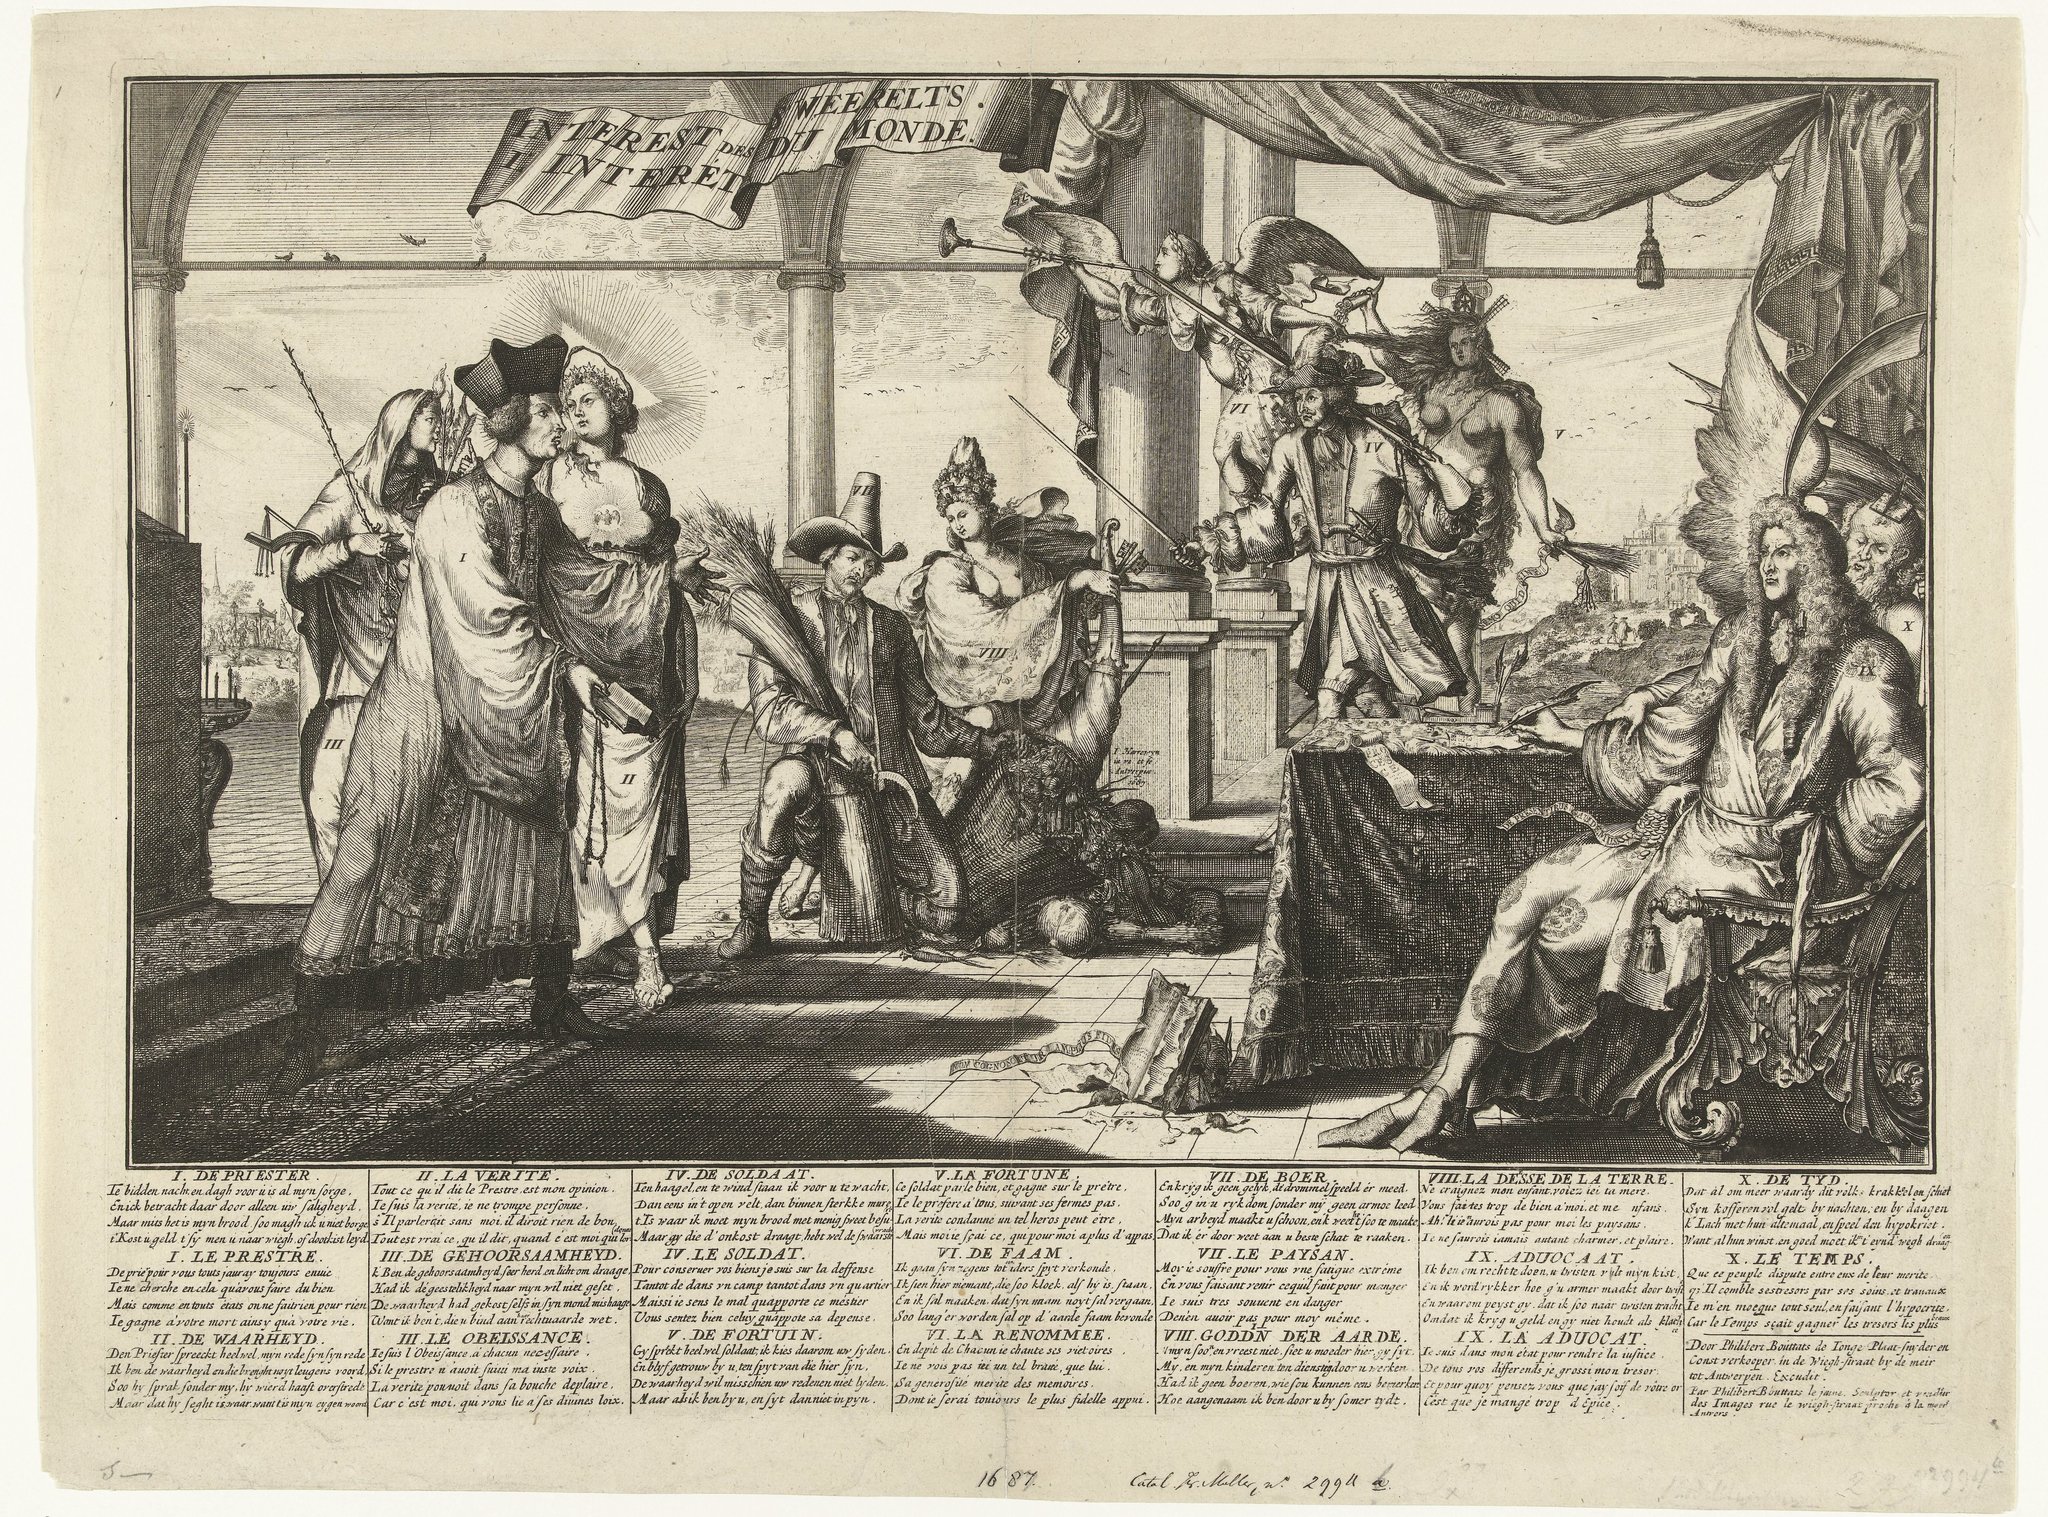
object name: cartoon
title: Spotprent op de advocatuur die garen spint bij het twisten van de mens, 1687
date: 1687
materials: paper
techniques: engraving, etching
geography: antwerp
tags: lawyer, attorney at law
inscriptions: date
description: Het interest van de wereld. Spotprent op de advocatuur die garen spint bij het twisten van de mens, 1687. Allegorie waarin een priester vergezeld door Gehoorzaamheid en Waarheid en een boer vergezeld door de godin van de aarde hun zaak bepleiten voor een achter zijn tafel gezeten advocaat die vergezeld wordt door de Tijd. Tussen de partijen in staat de soldaat met Fortuin en Faam. In het onderschrift de verzen behorend bij de hoofdpersonen genummerd I-X in het Nederlands en Frans.